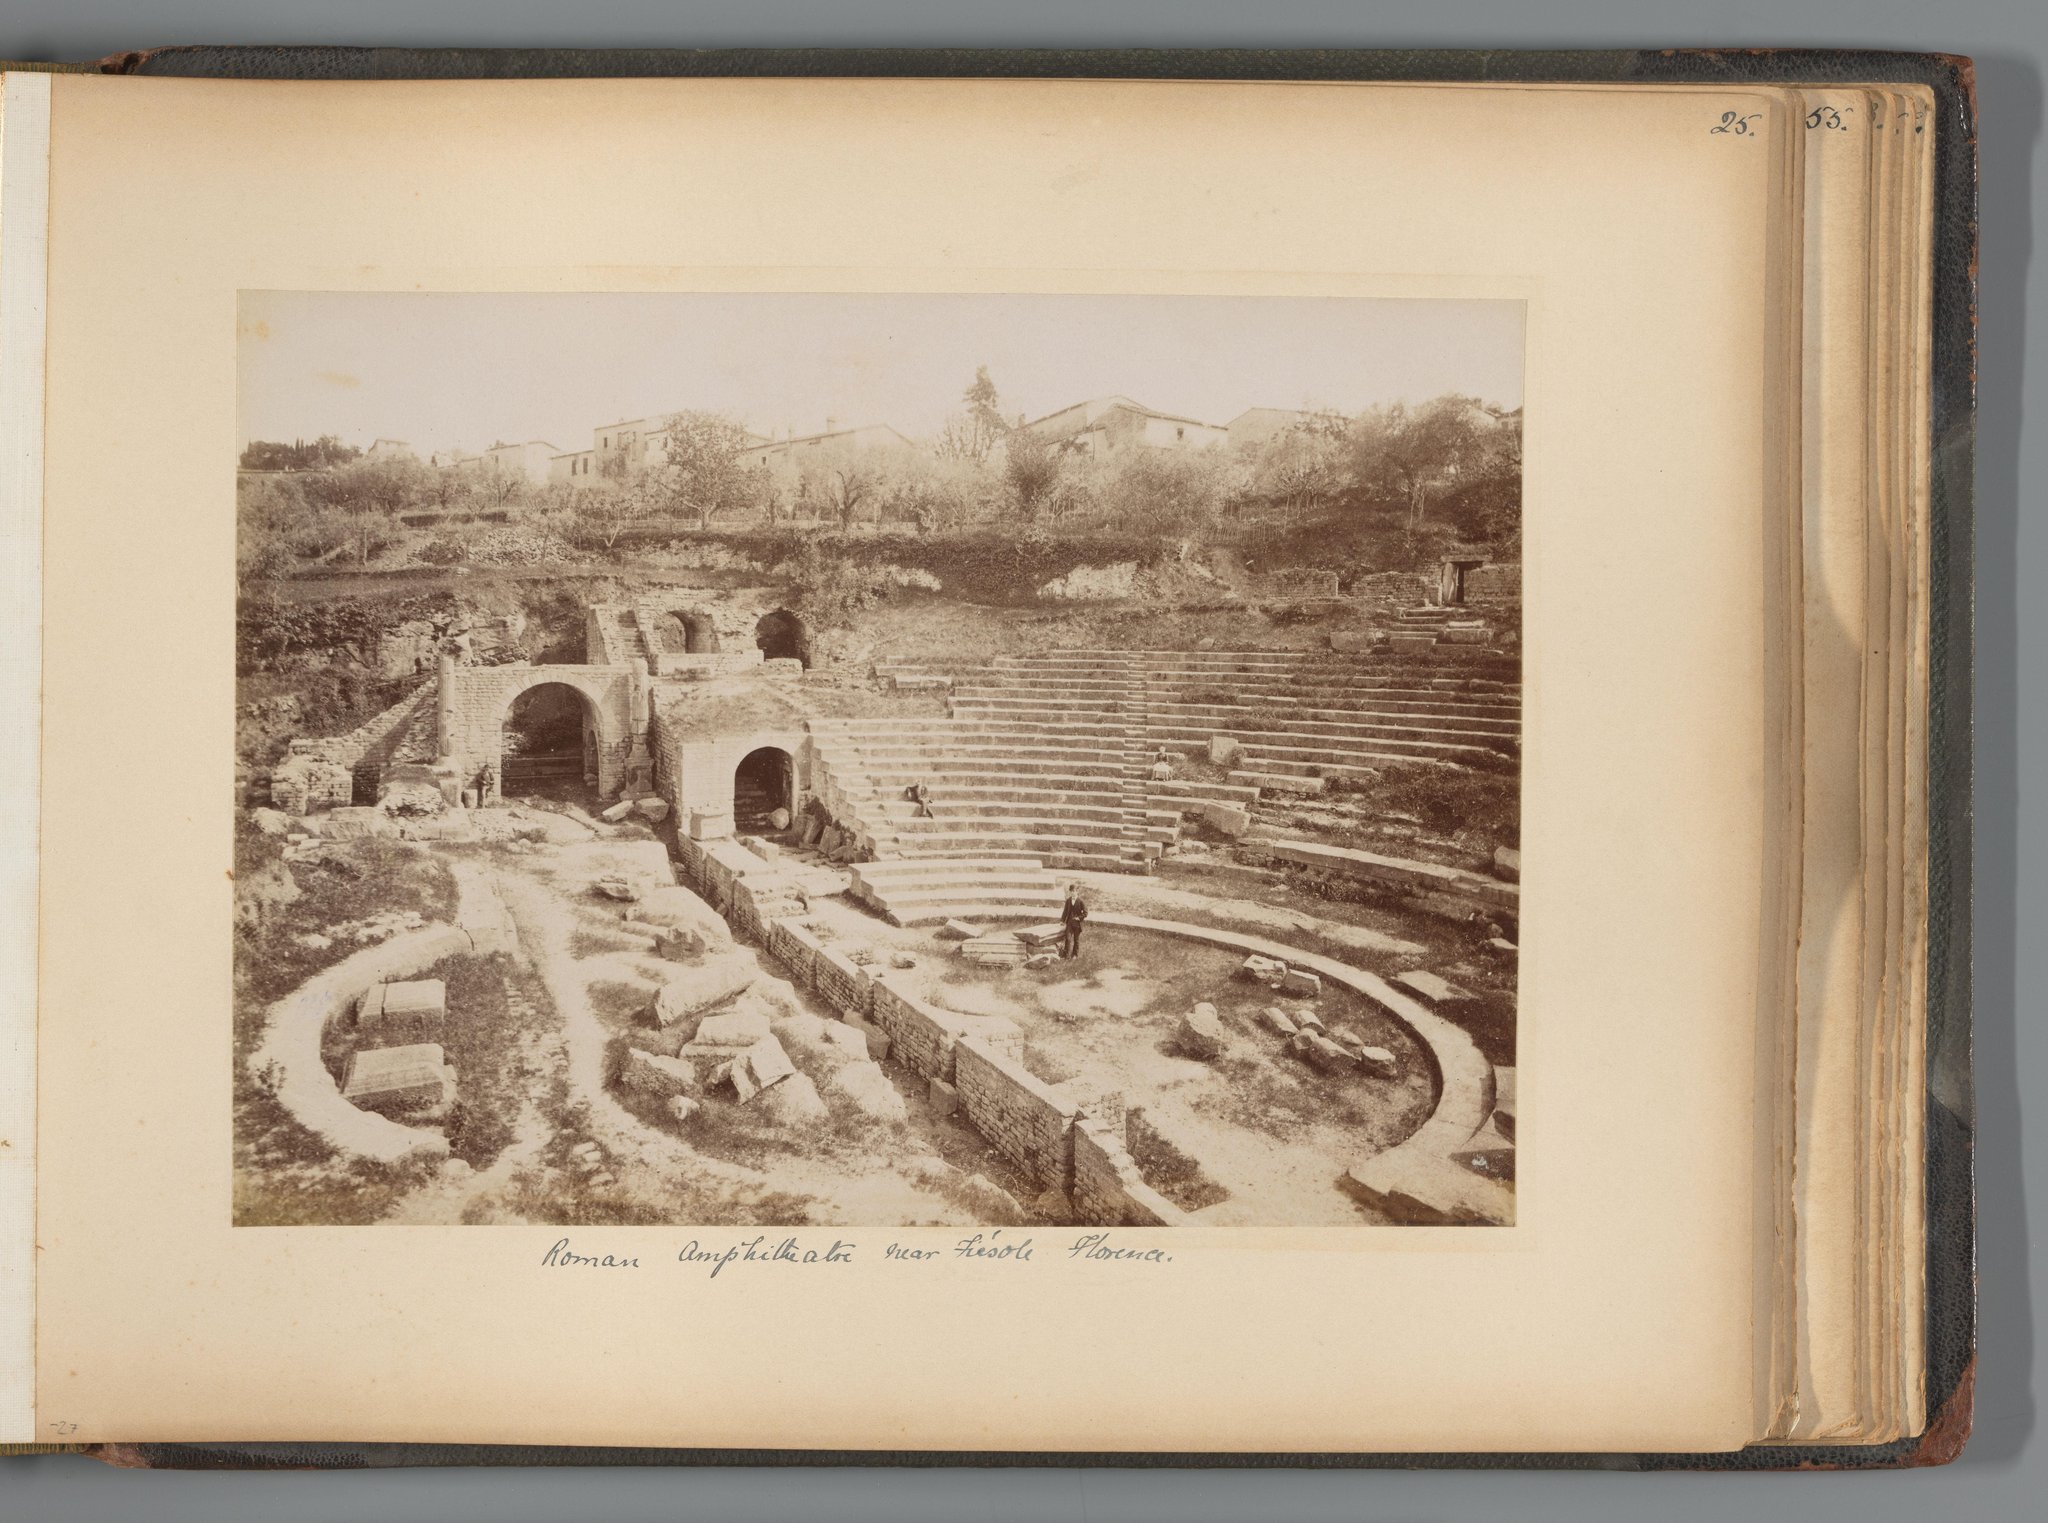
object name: album leaf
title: Roman Amphitheatre near Fiesole, Florence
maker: c.c. blackburn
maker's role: fotograaf, luitenant-kolonel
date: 1877-1892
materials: paper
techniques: albumen print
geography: fiesole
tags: amphitheatre